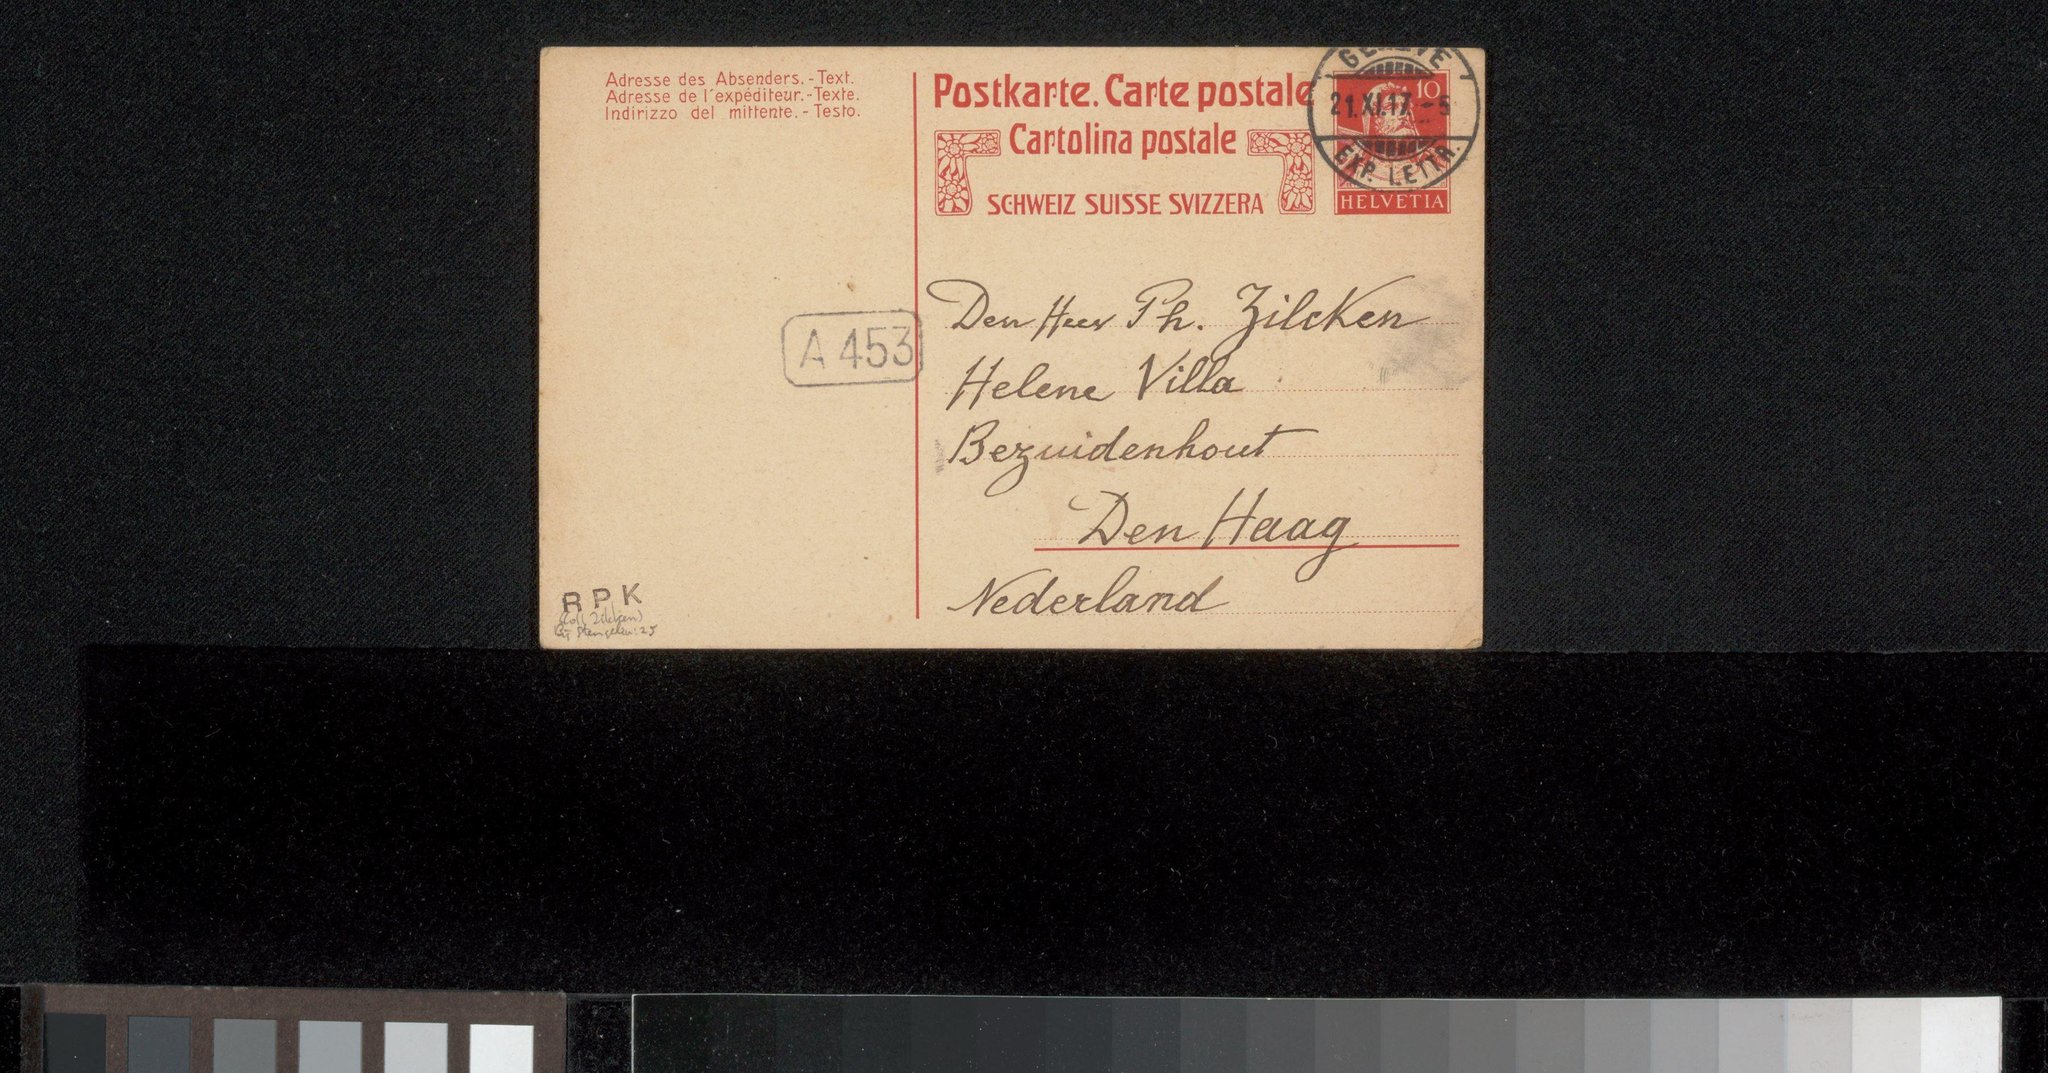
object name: postcard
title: Briefkaart aan Philip Zilcken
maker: alphonse stengelin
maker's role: painter, print maker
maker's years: 1852-1938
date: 1917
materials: cardboard, ink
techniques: pen, writing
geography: satigny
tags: the hague, draughtsman, philip zilcken, java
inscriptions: collector's mark: ‘RPK’